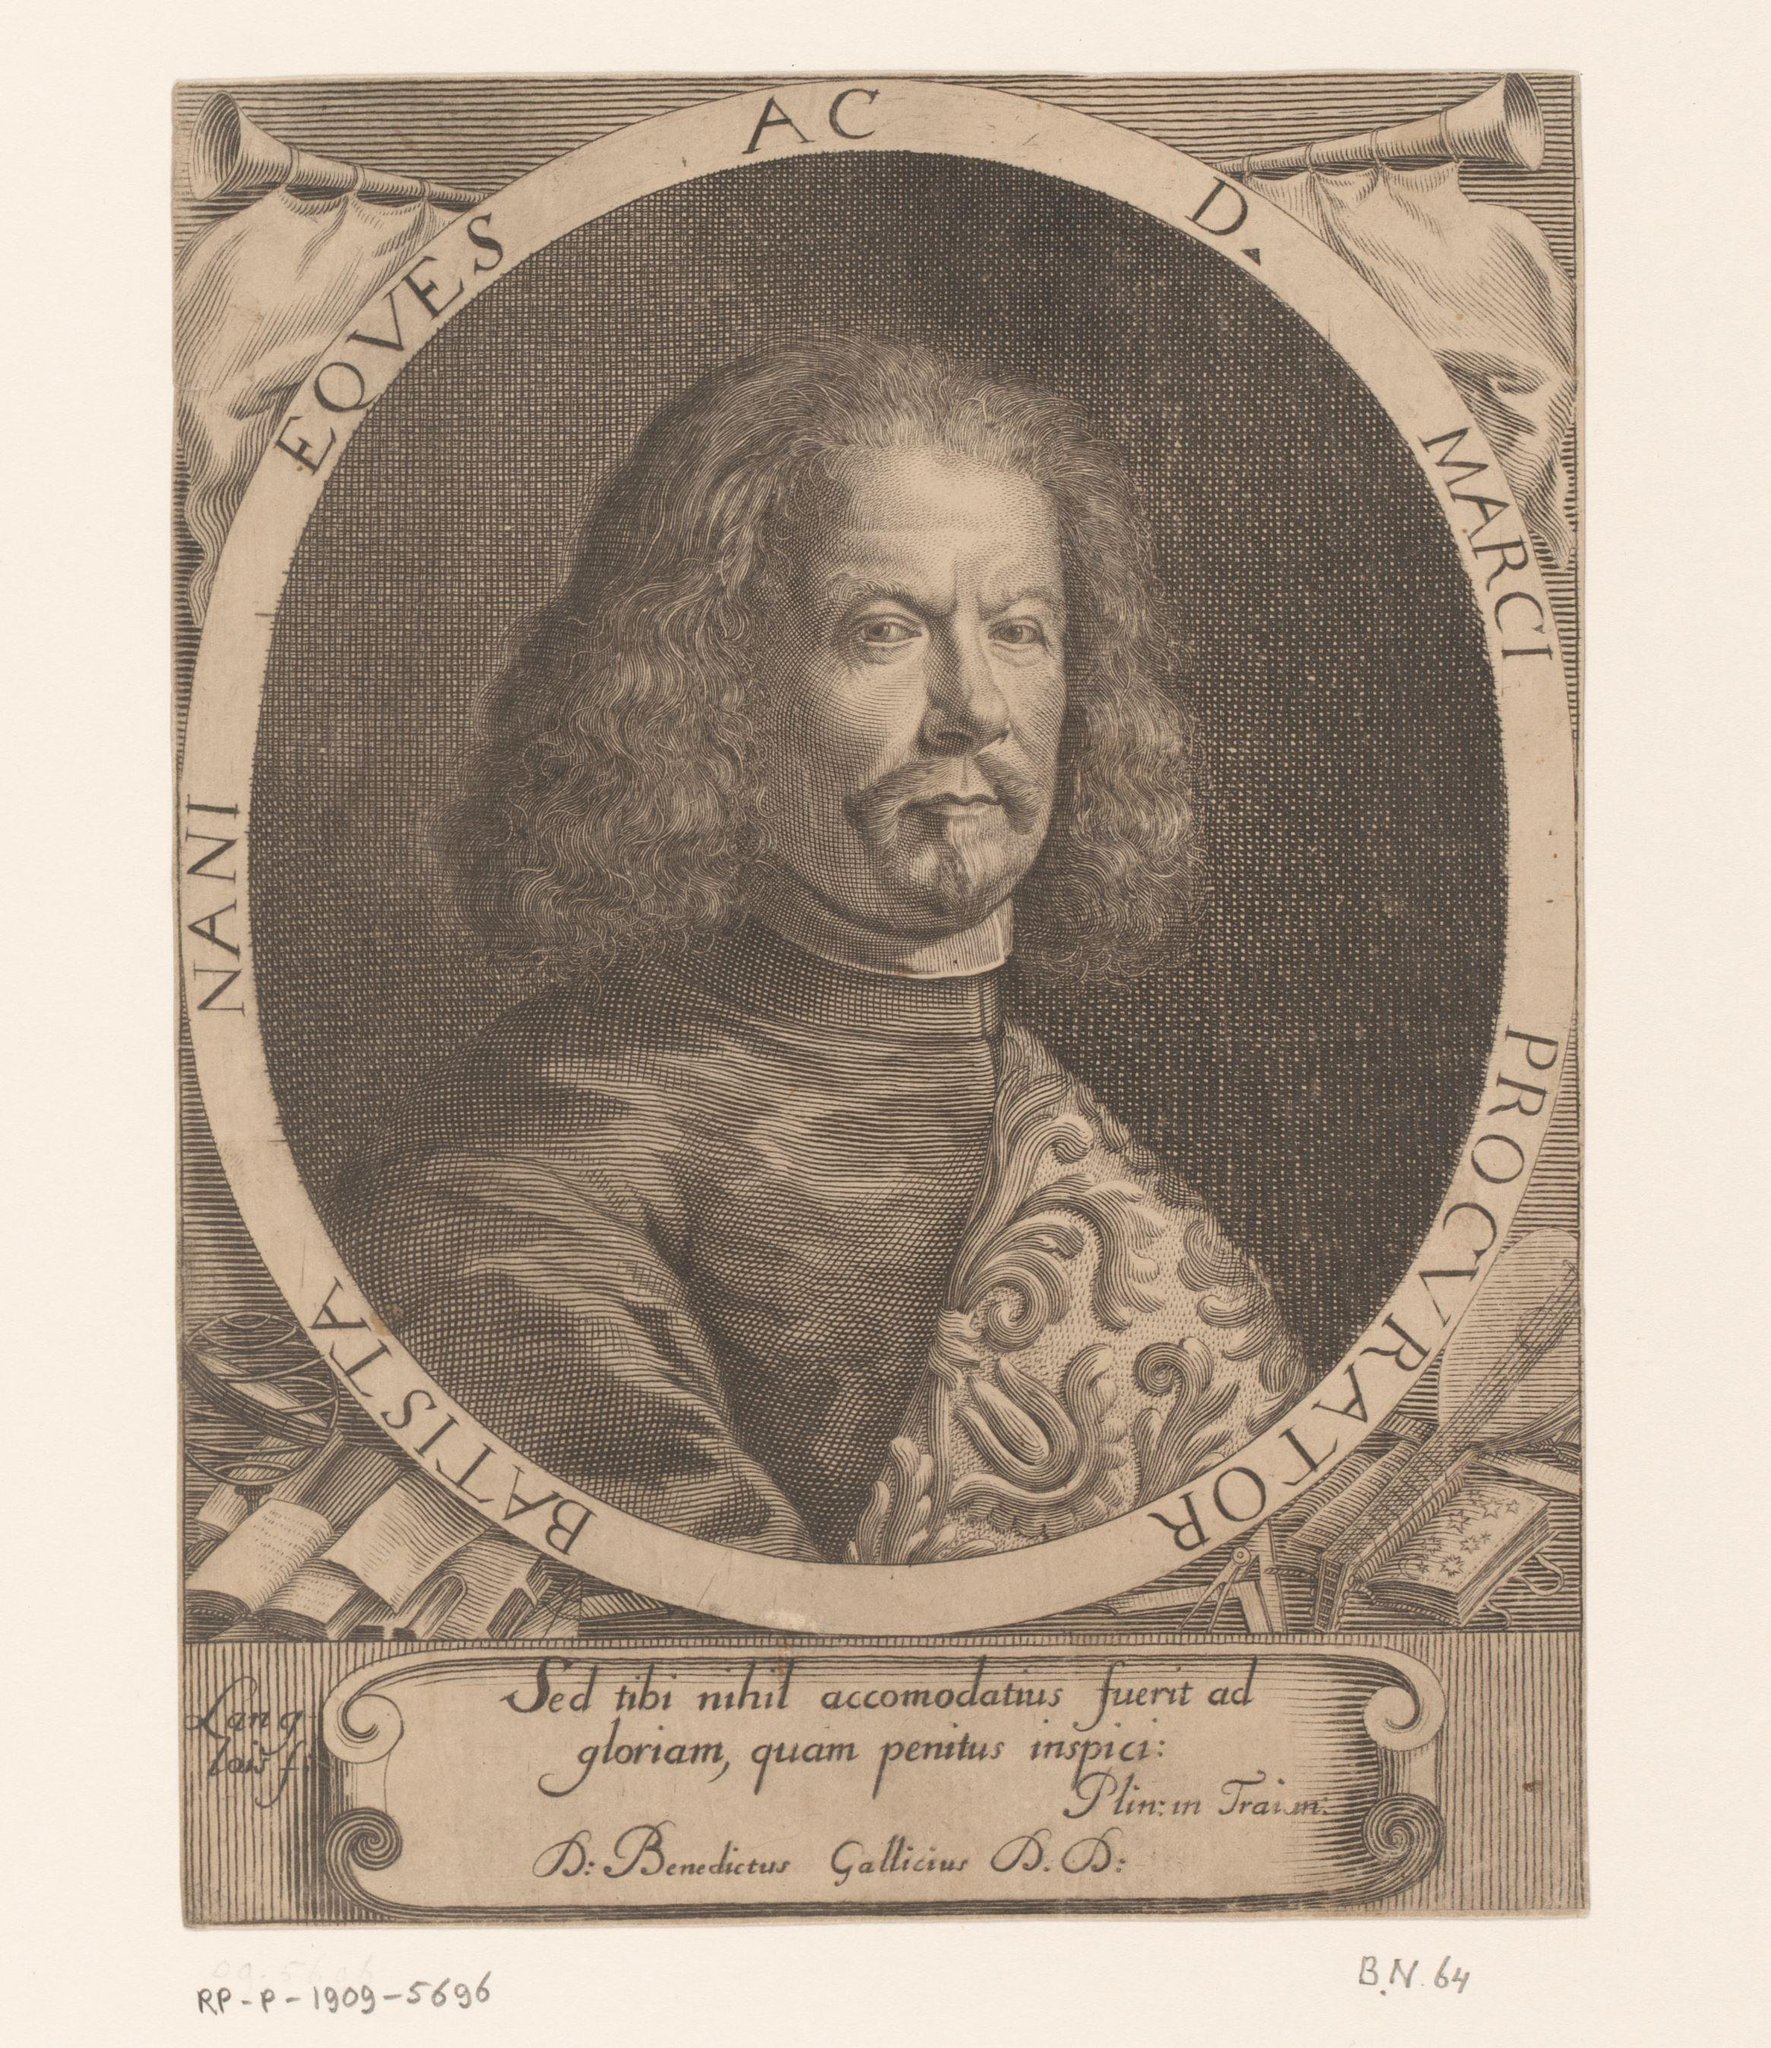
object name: print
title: Portret van Giovan Battista Nani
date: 1659-1712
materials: paper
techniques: engraving, etching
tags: venice, historical persons, portrait of a writer, diplomacy, diplomat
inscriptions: collector's mark: Lugt 2228